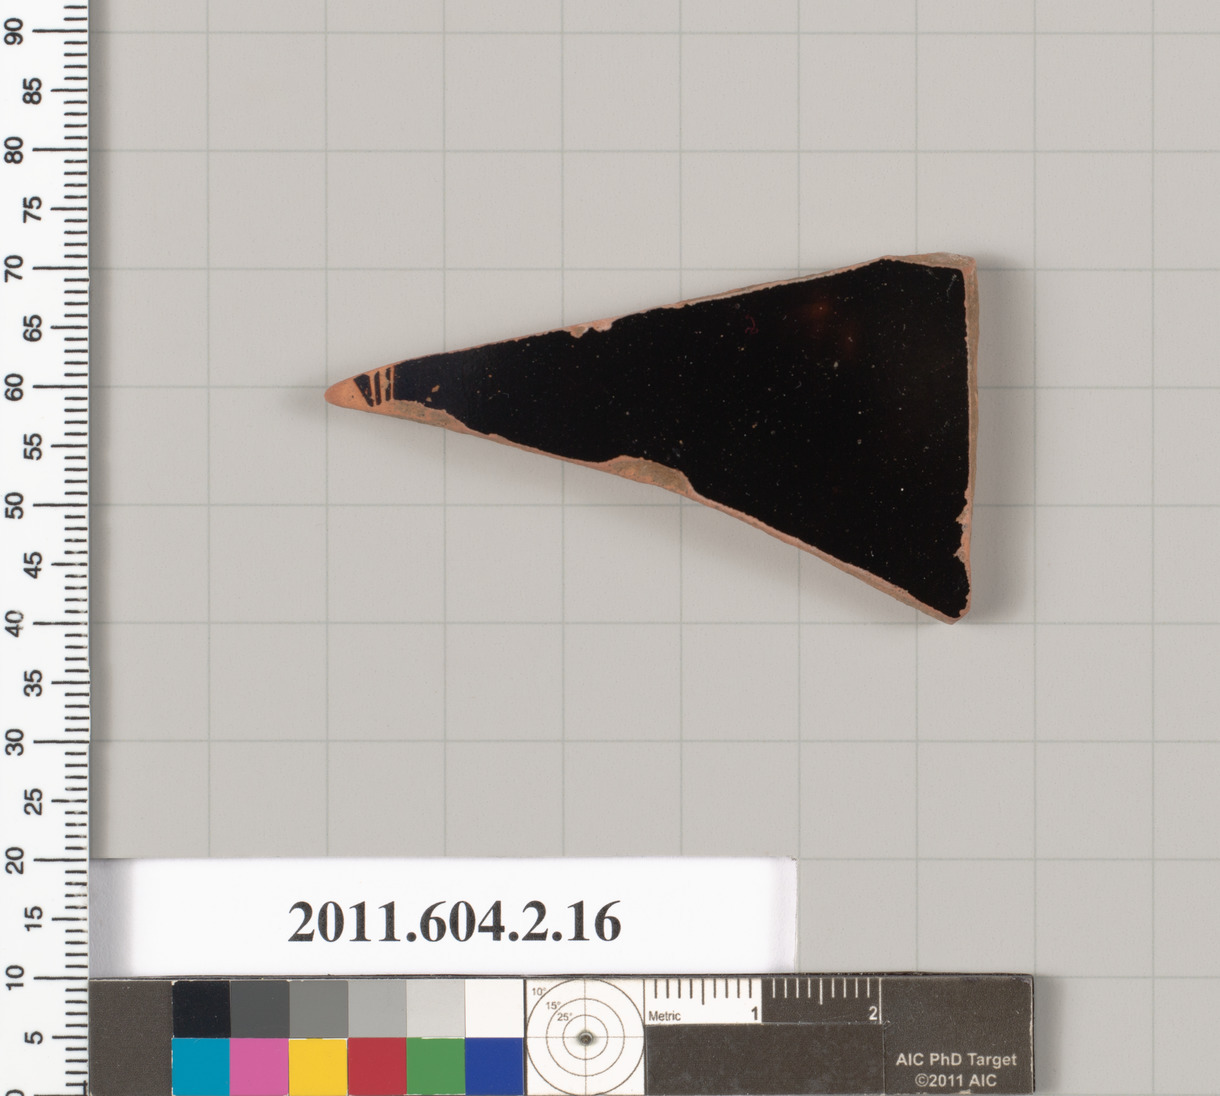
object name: neck amphora fragment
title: Terracotta fragment of a neck-amphora (jar)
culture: greek, attic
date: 500-476 BCE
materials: terracotta